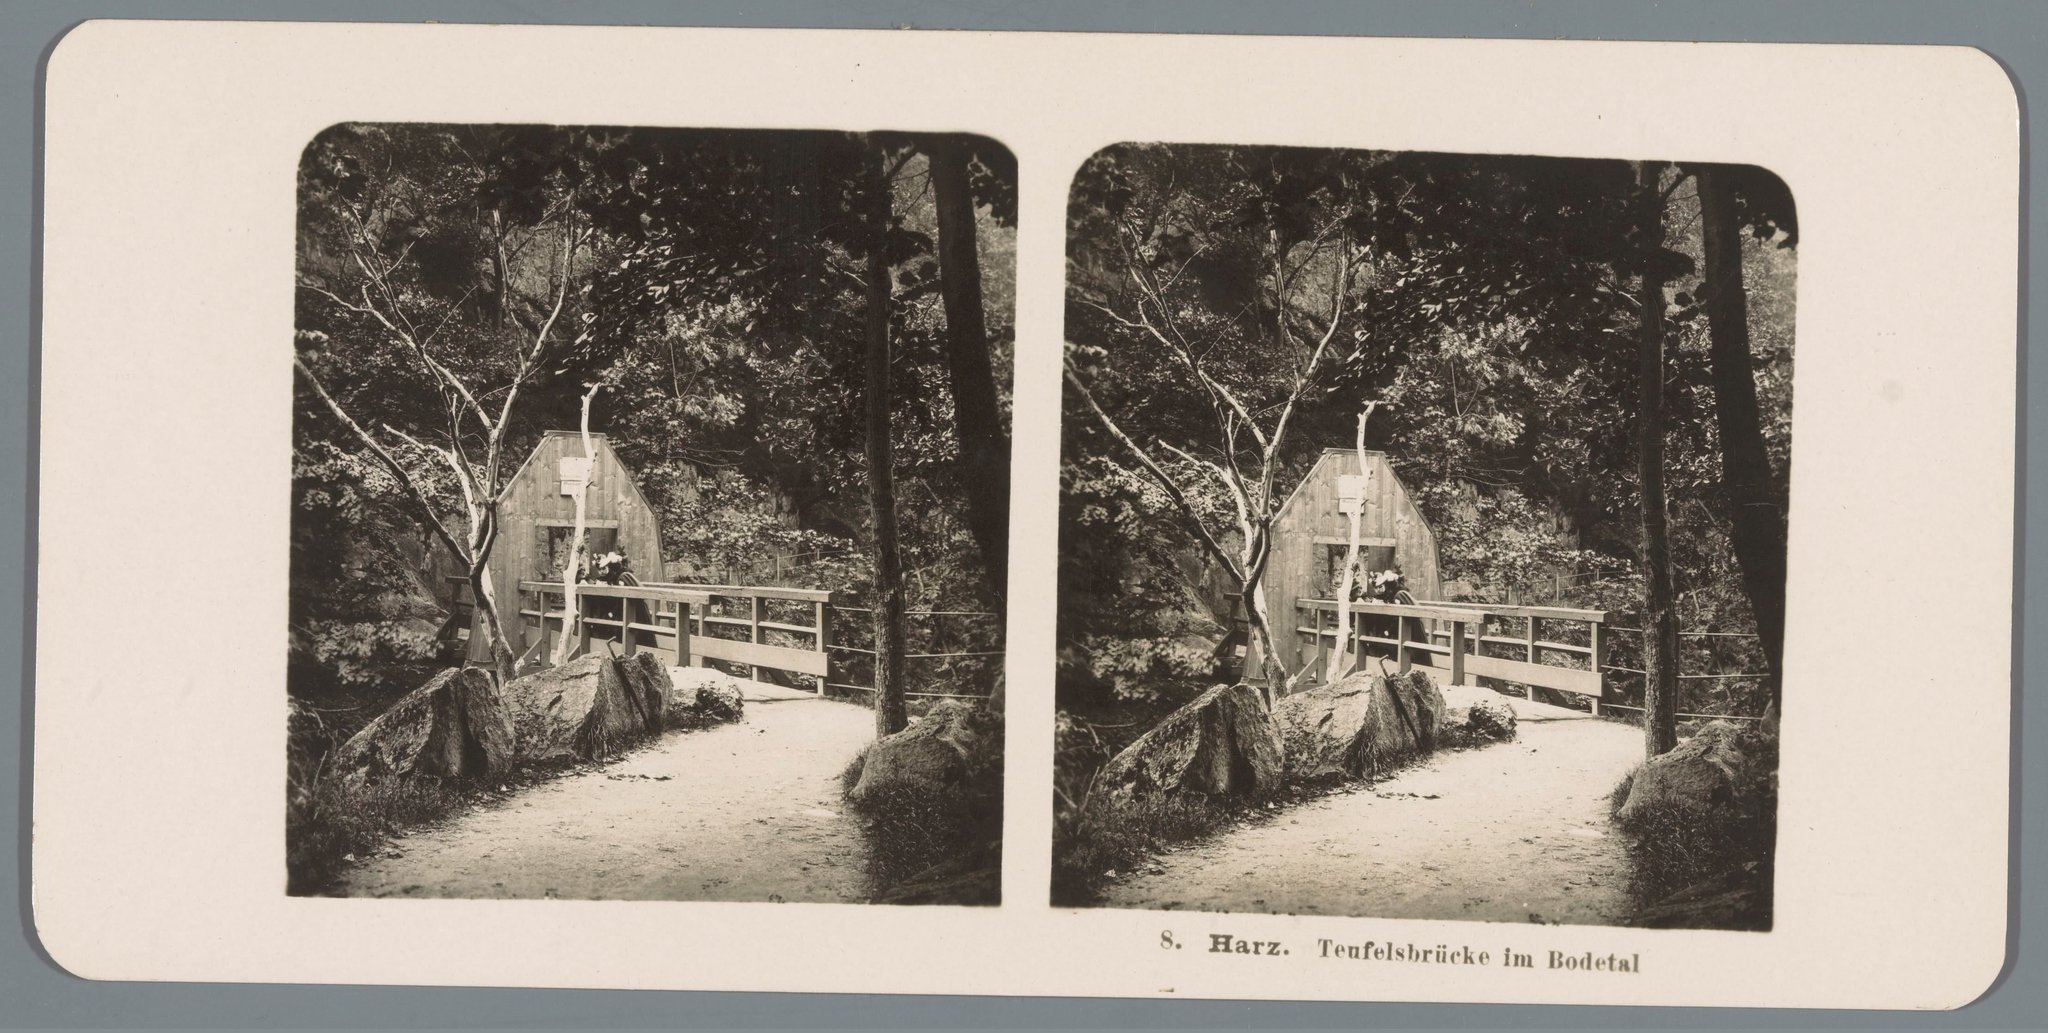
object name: stereograph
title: Gezicht op de Teufelsbrücke in het Bodetal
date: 1906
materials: cardboard, photographic support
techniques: gelatin silver print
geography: bodetal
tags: dale, valley, bridge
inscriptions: inscription: ‘Neue Photographische Gesellschaft A. G., Steglitz-Berlin 1906.’, number: ‘8.’